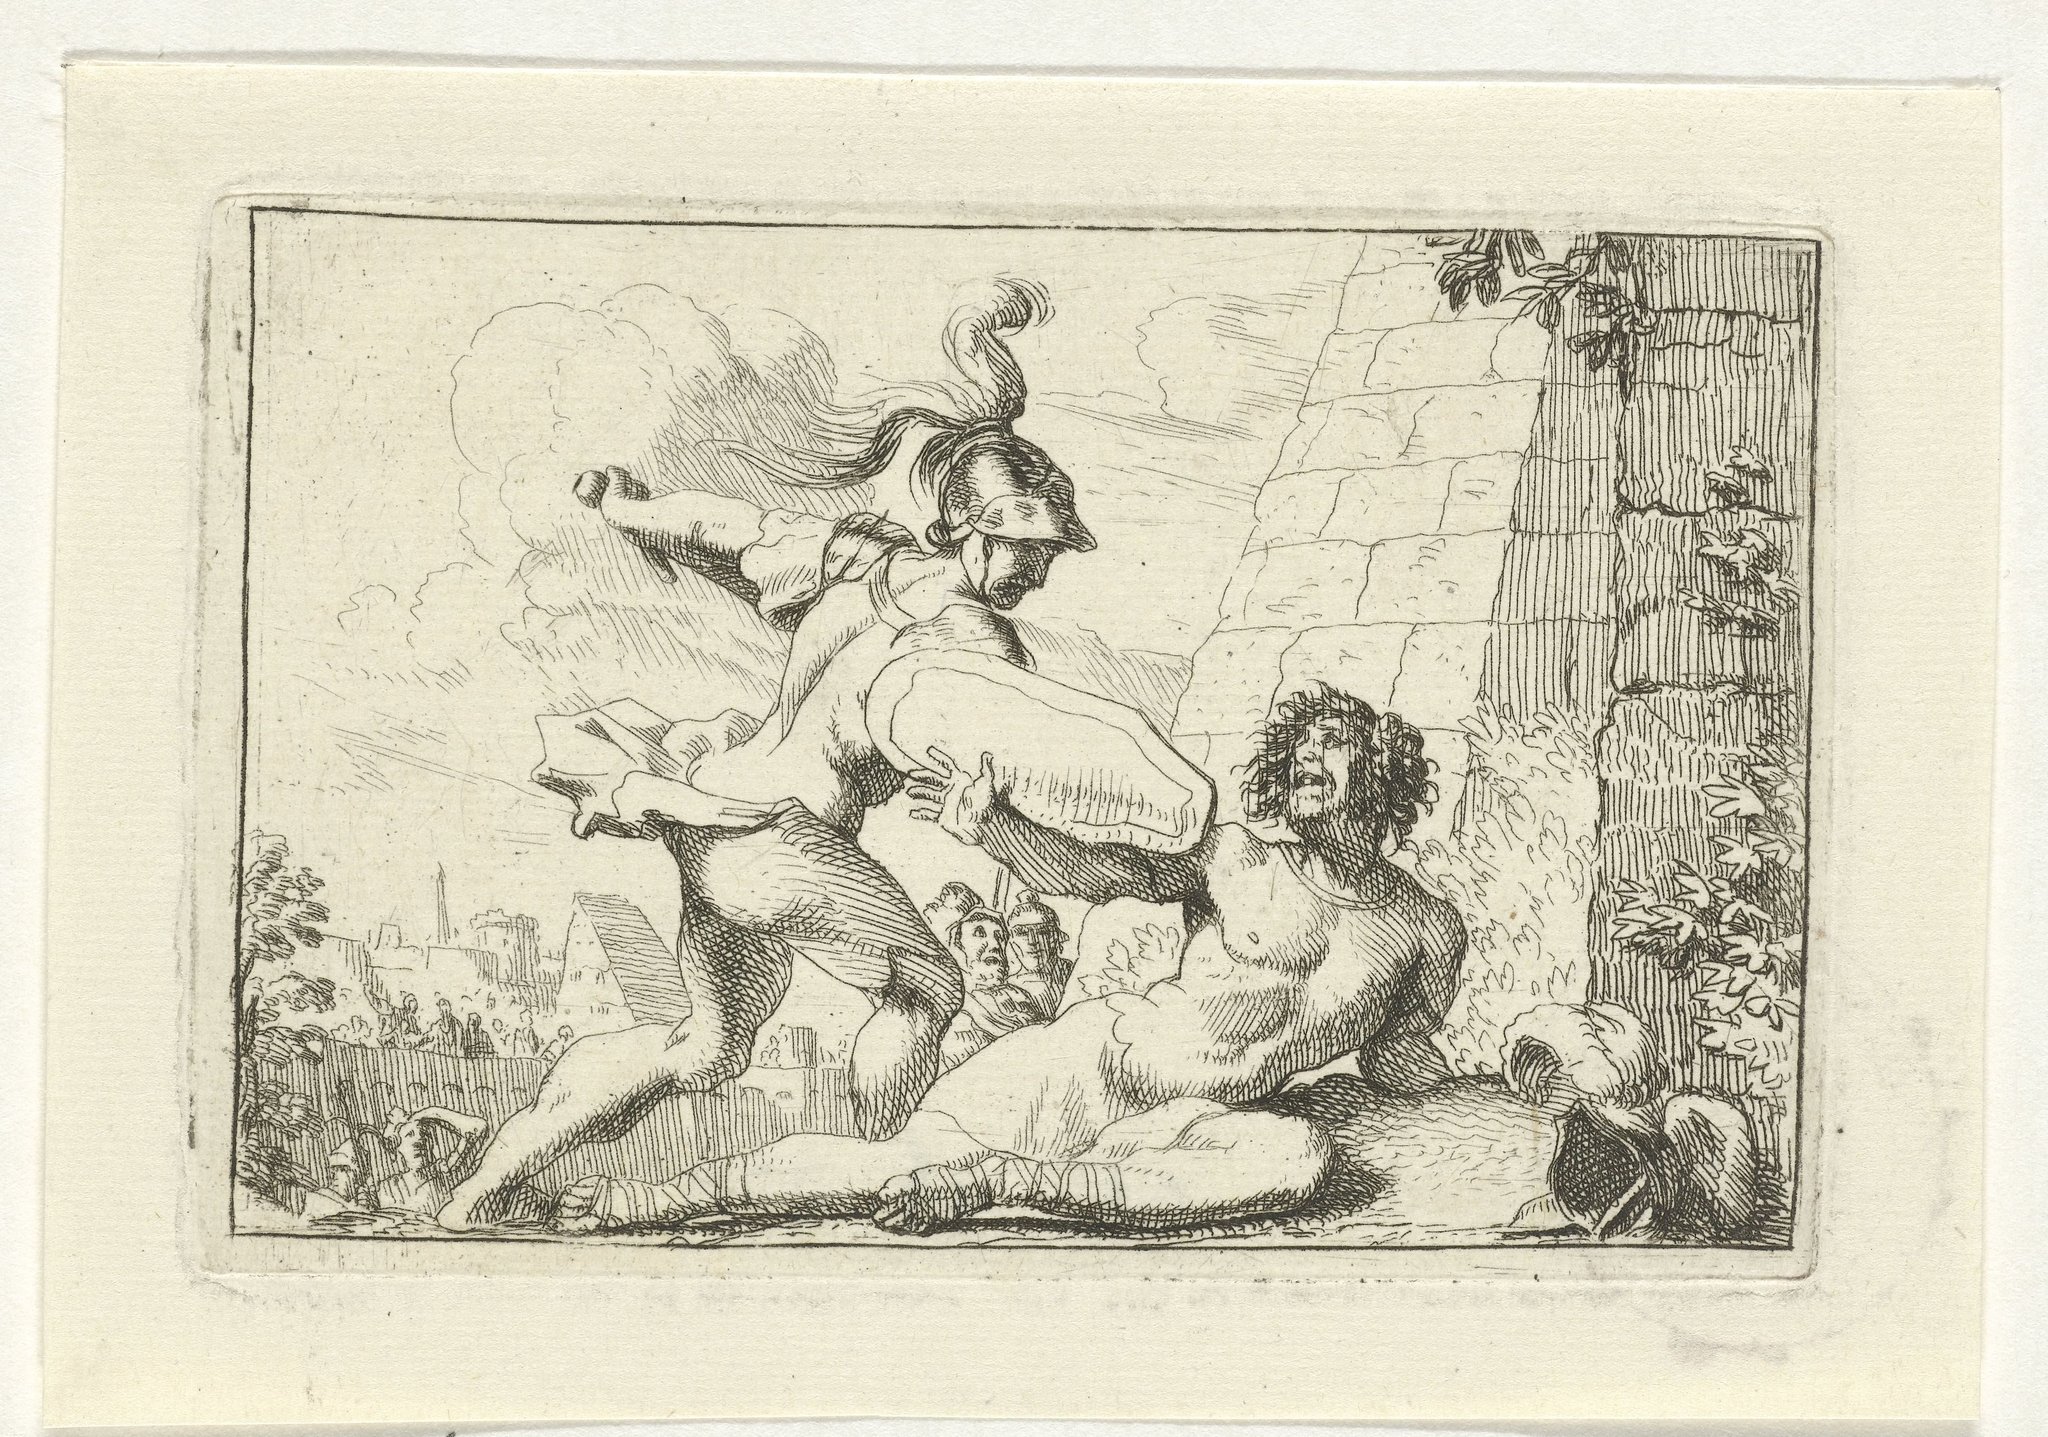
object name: print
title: Geschiedenis van Dido en Aeneas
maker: gerard de lairesse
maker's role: draughtsman, painter, print maker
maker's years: 1641-1711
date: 1668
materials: paper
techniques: etching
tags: single combat of turnus and aeneas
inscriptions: collector's mark: Lugt 240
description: Tweegevecht tussen Aeneas en Turnus. Turnus ligt reeds op de grond en kijkt angstig naar het zwaard dat Aeneas naar hem uithaalt. De prent maakt deel uit van een zesdelige serie prenten met scènes uit het mythologische verhaal van Dido en Aeneas.